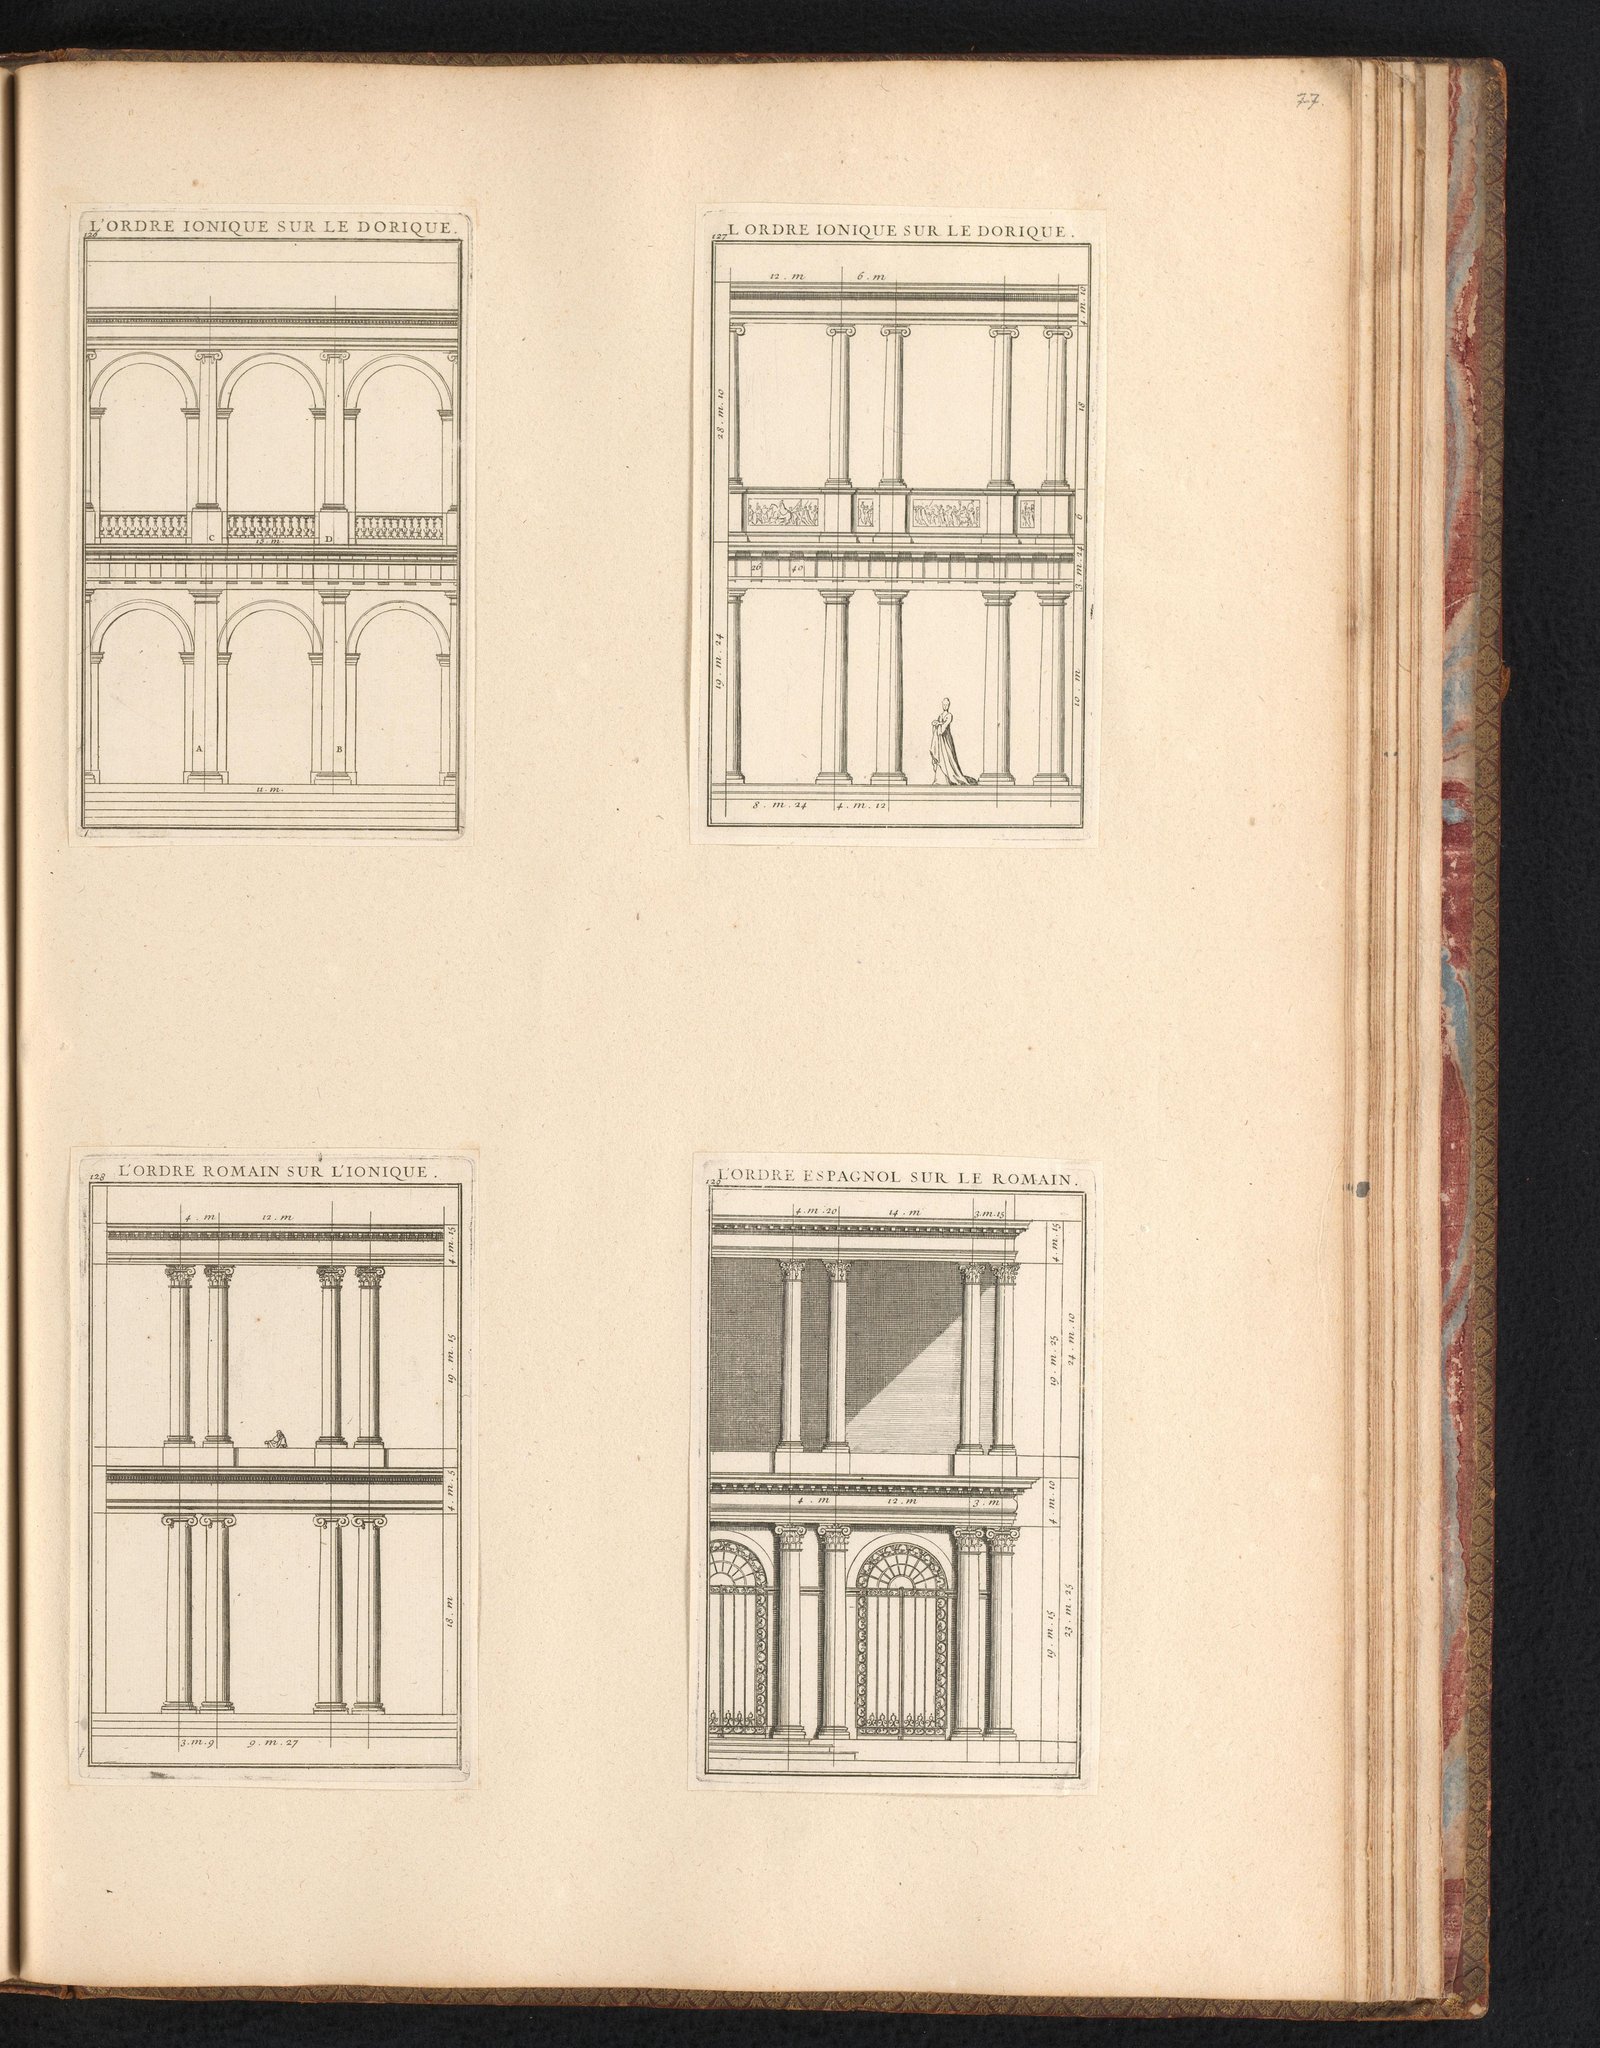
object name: album leaf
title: L'Ordre Ionique sur le Dorique/ L'Ordre Romain sur l'Ionique (...)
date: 1714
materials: paper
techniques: etching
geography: paris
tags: colonnade, orders, order-books ~ architecture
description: Prenten uit: Leclerc, Sébastien (I). Traité d'architecture. Parijs: Pierre François Giffart, 1714.